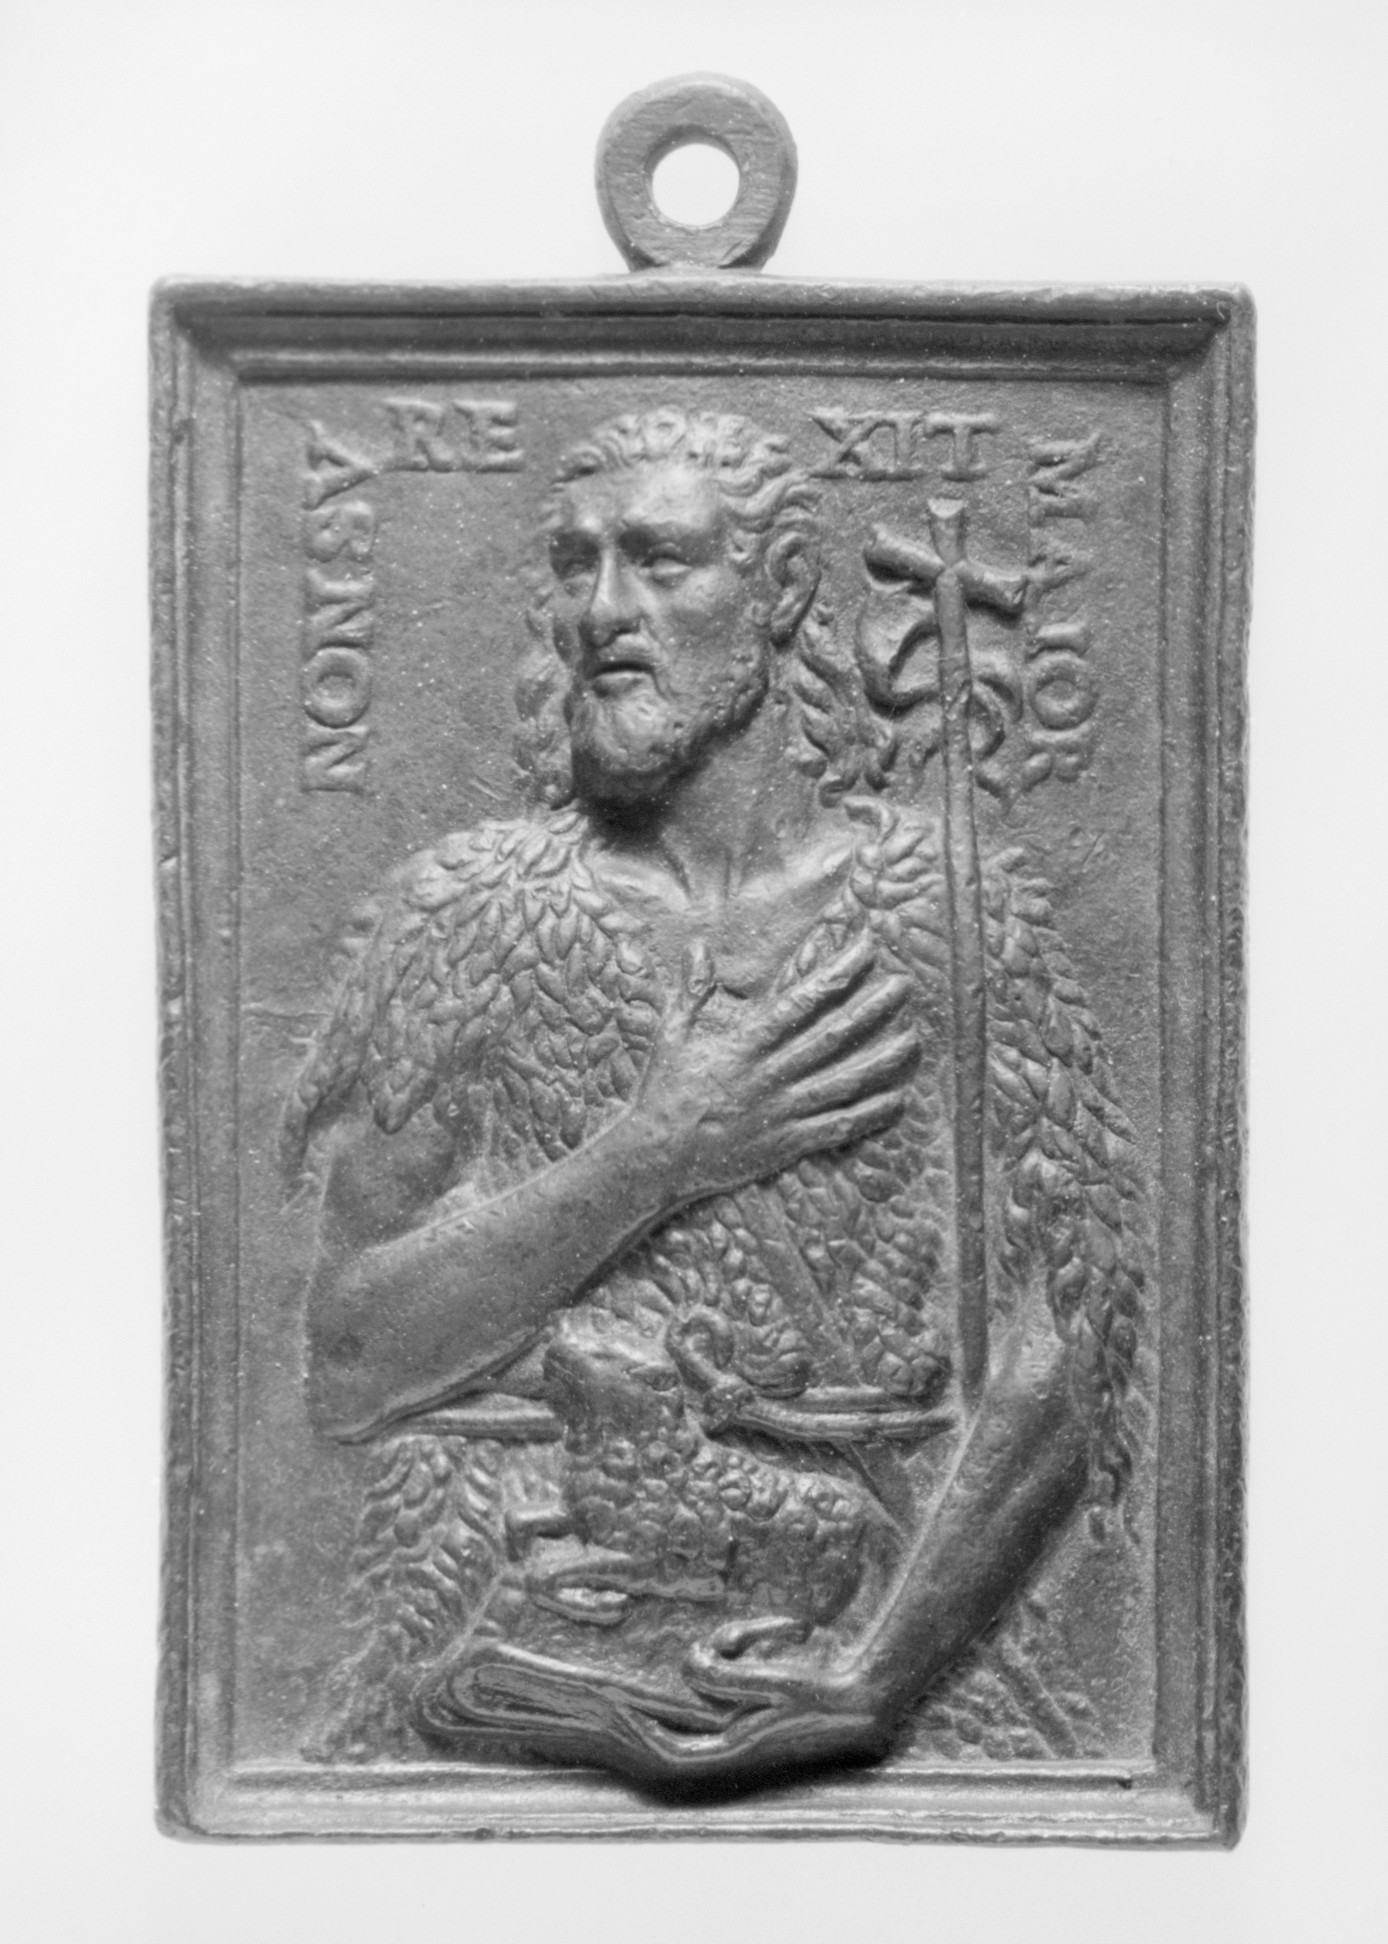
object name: plaquette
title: St. John the Baptist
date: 1567-1600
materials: bronze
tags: animals,portraits,saint john the baptist